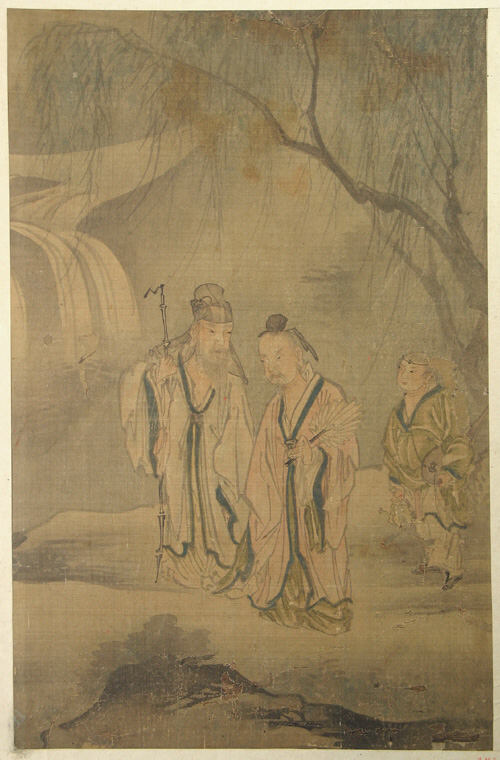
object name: album leaf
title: Scholars Strolling by the Waterfall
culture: korean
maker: unidentified artist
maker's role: artist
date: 1650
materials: ink, silk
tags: men,waterfalls